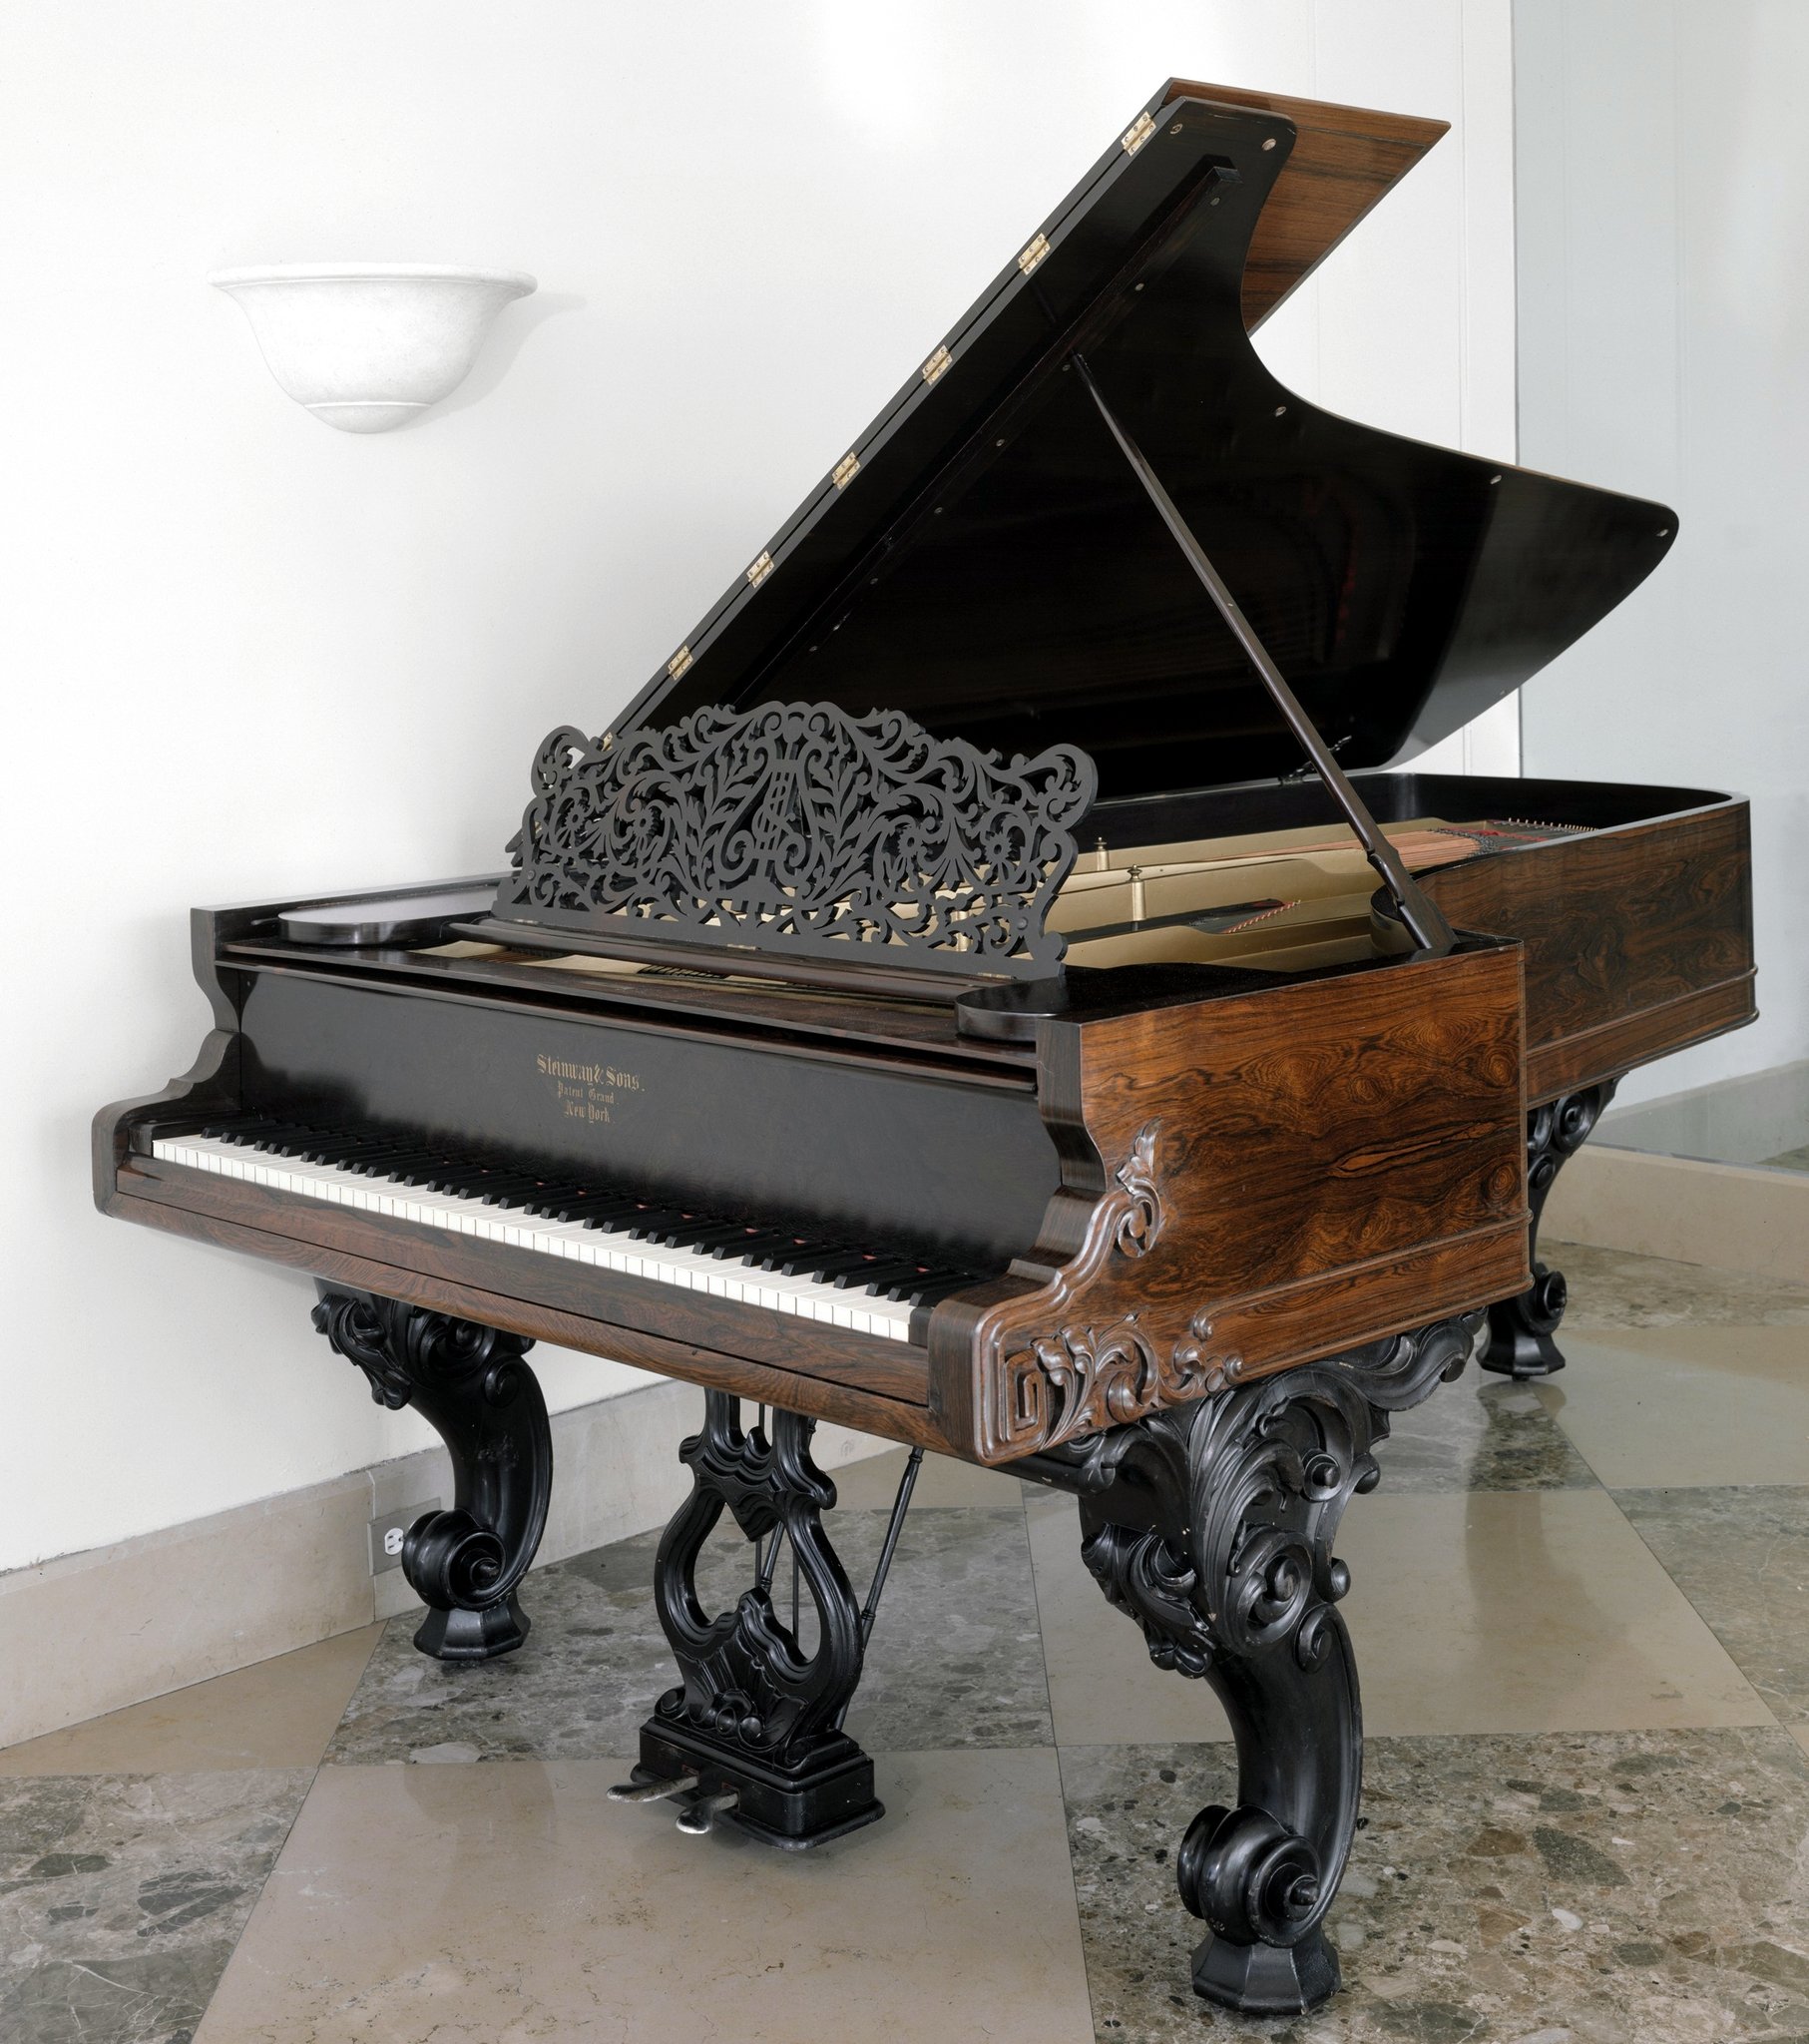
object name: grand piano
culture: american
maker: steinway & sons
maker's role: maker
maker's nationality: american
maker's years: 1853-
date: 1868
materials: metal, wood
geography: united states